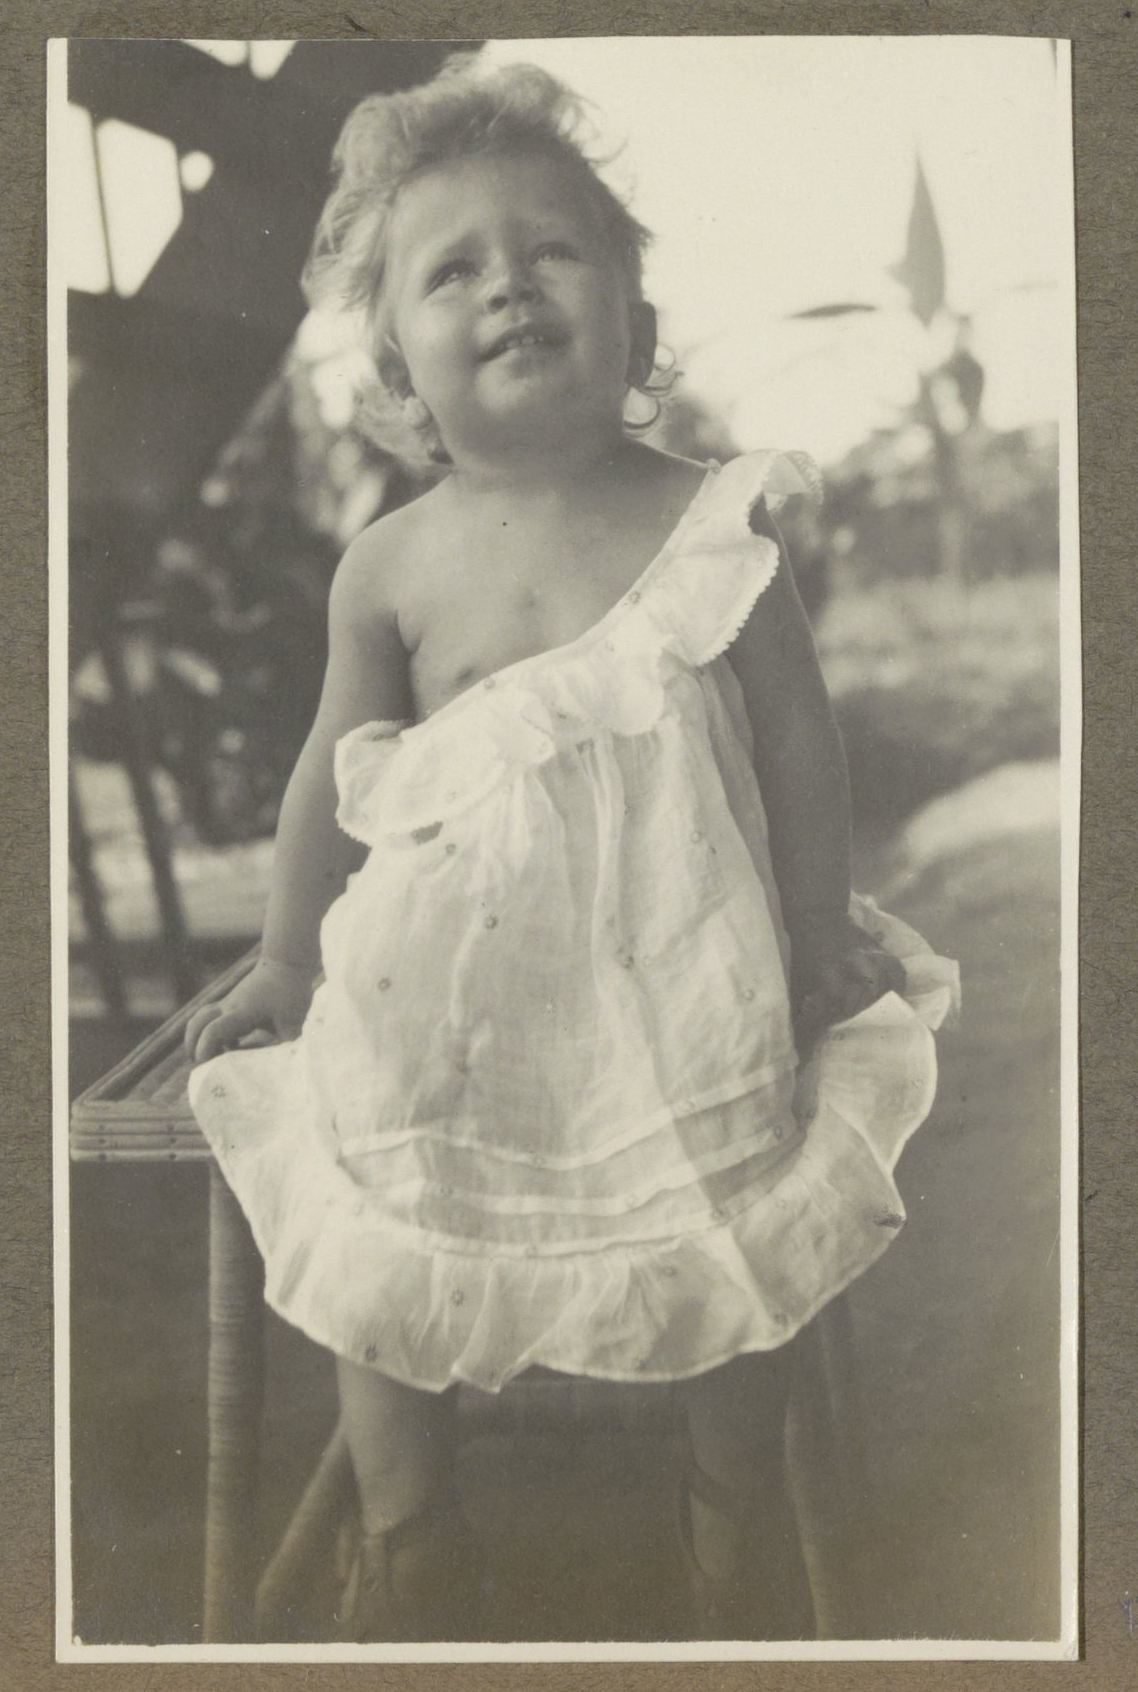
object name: photograph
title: Familie Janschen te Medan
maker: Anonymous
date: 1920-1930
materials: photographic support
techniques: gelatin silver print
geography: medan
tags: child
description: Onderdeel van fotoalbum van een onbekende Nederlandse familie met opnames van Suriname, Europa en Nederlands-Indië.